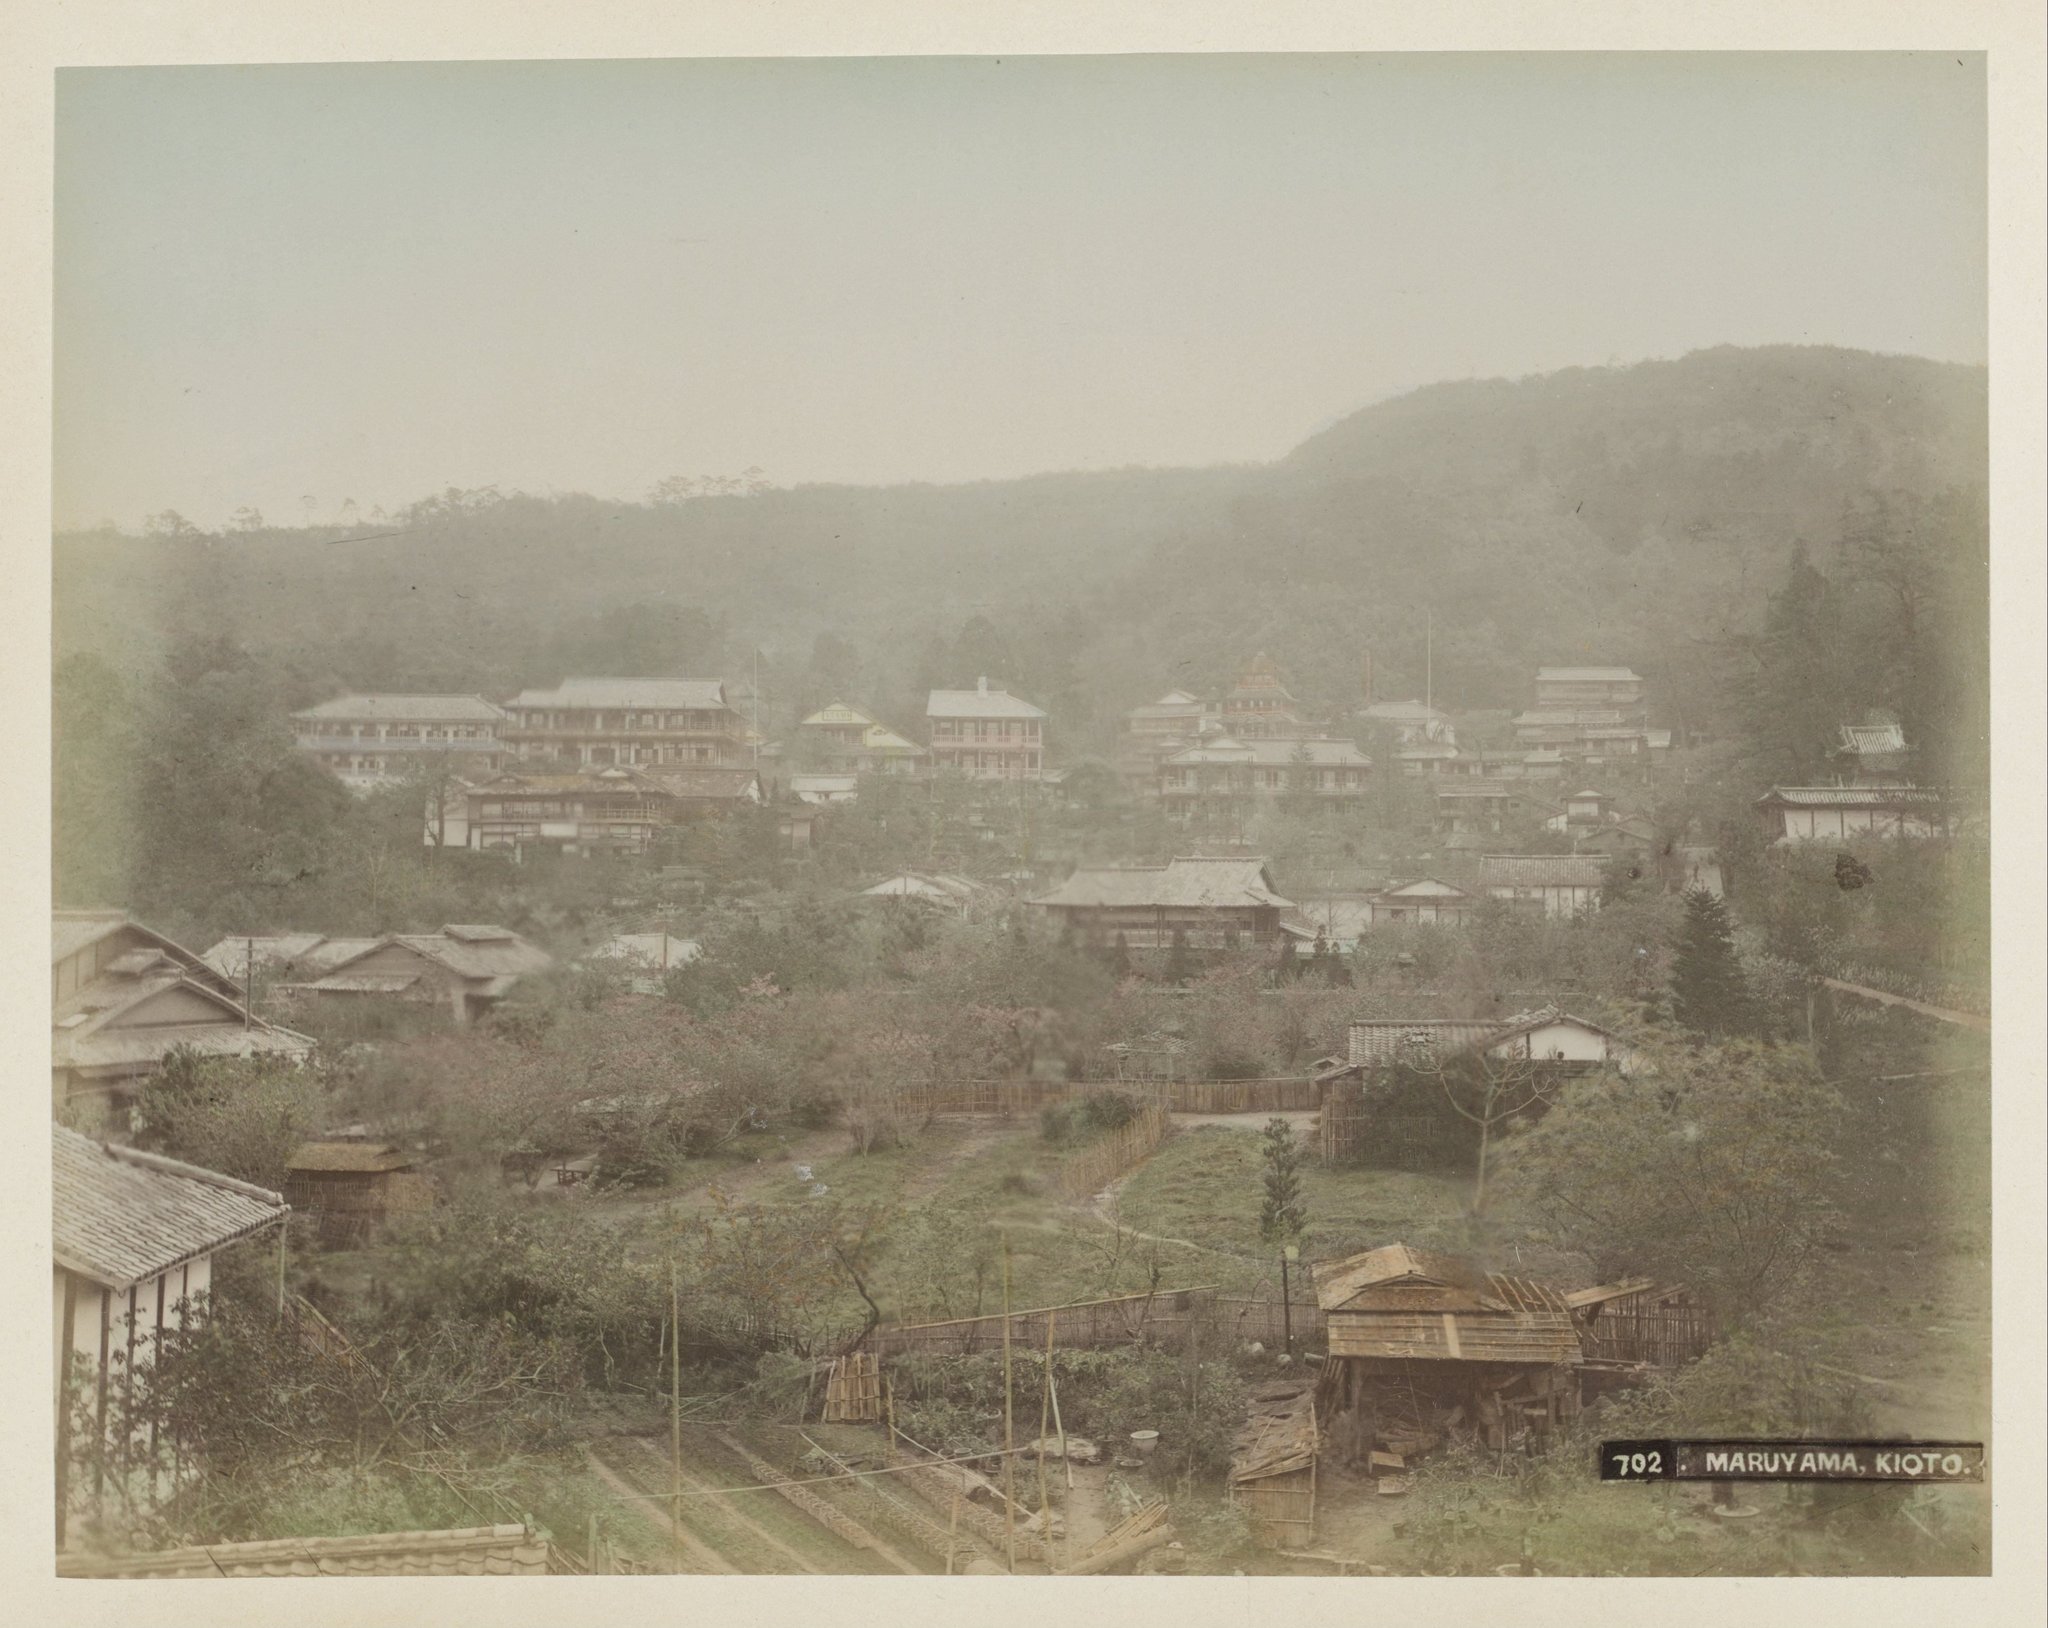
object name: photograph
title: Gezicht op het dorp Maruyama bij Kyoto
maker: Anonymous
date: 1870-1900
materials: paper, photographic support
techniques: albumen print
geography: kyoto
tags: prospect of village, silhouette of village, travelling; tourism, mountains, kyoto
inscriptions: negative number: ‘702’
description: Onderdeel van Fotoalbum met 50 foto's van bezienswaardigheden in Japan.